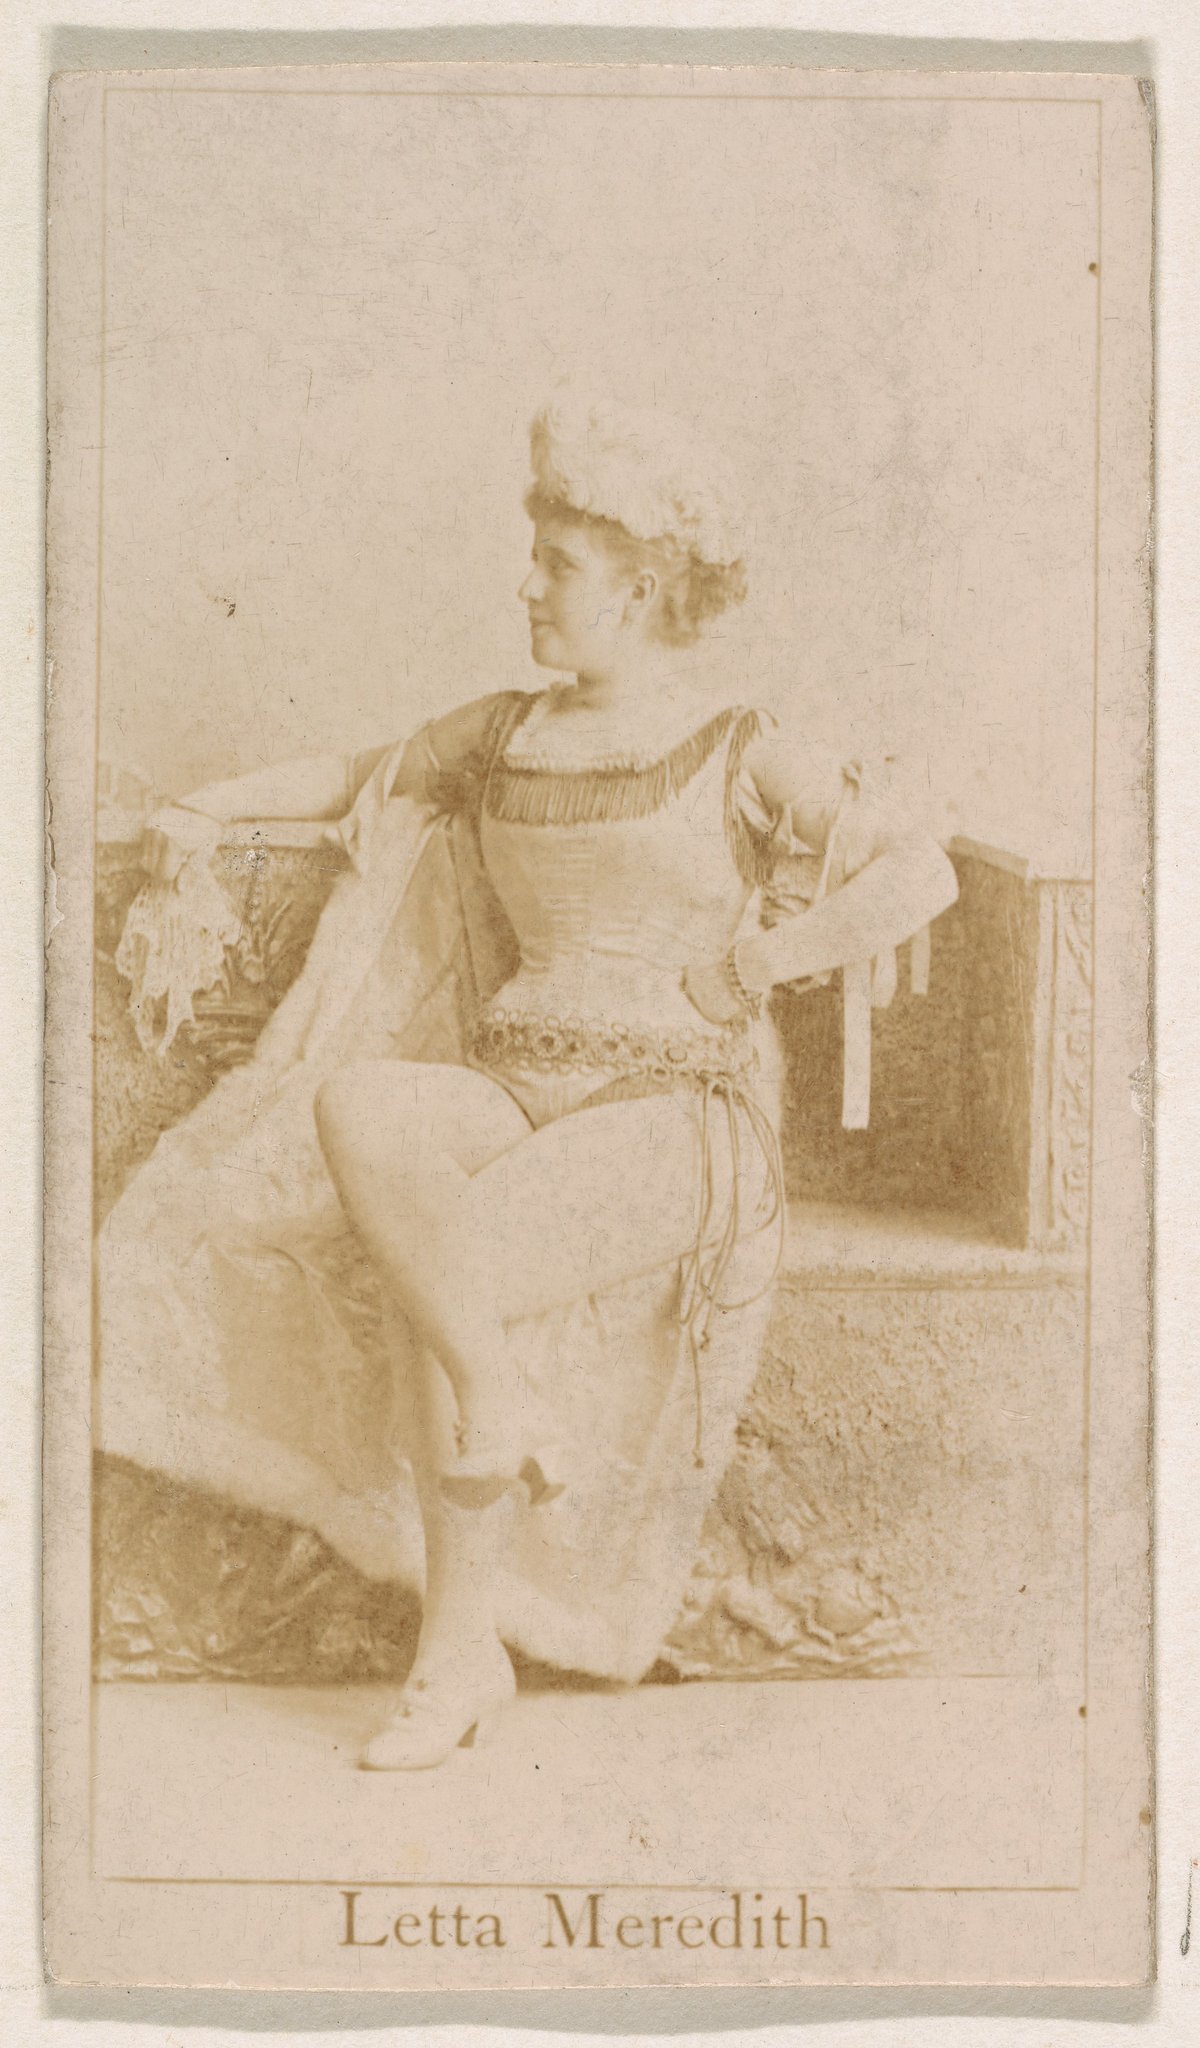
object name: photograph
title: Letta Meredith, from the Actresses series (N245) issued by Kinney Brothers to promote Sweet Caporal Cigarettes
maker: kinney brothers tobacco company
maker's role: publisher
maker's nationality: american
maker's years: 1869-2011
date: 1890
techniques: albumen silver print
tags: women,actresses